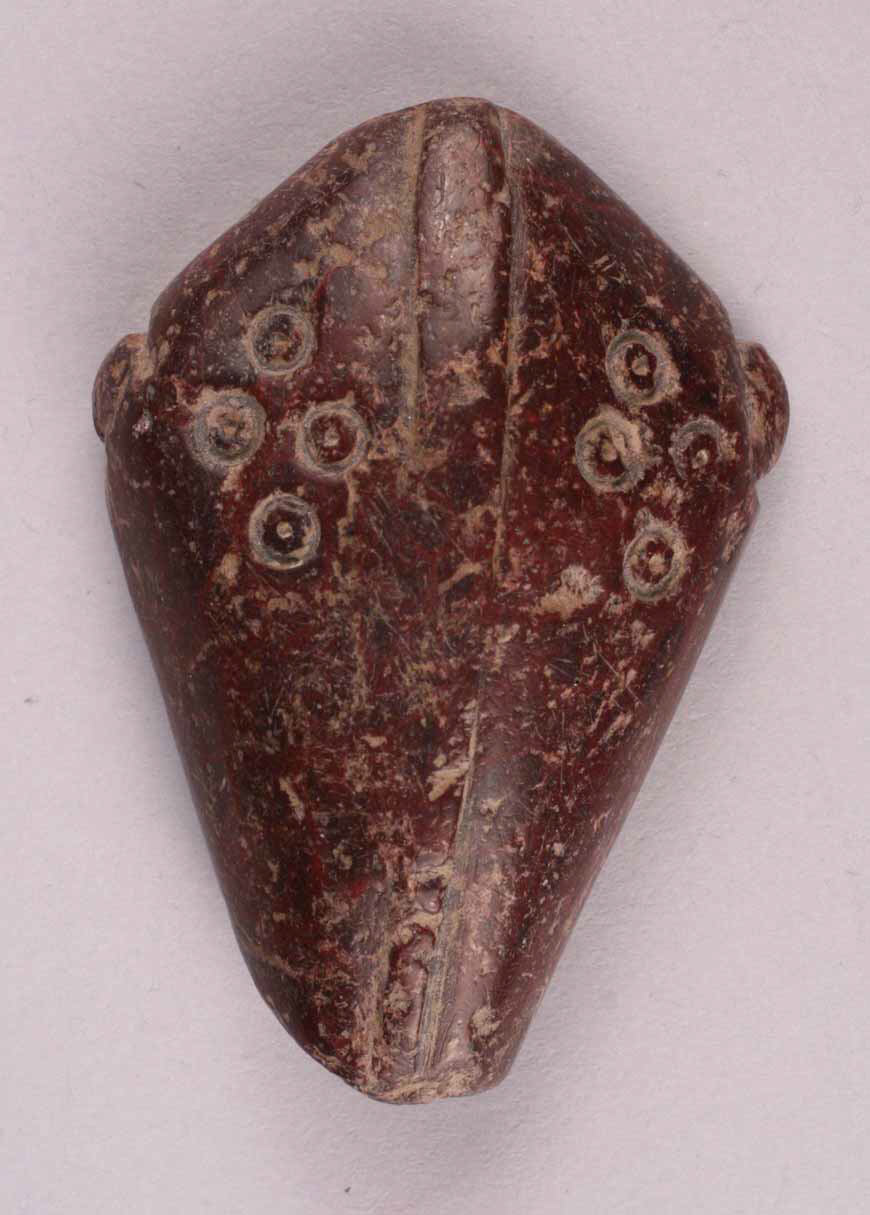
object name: bead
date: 701-1300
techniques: cutting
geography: iran